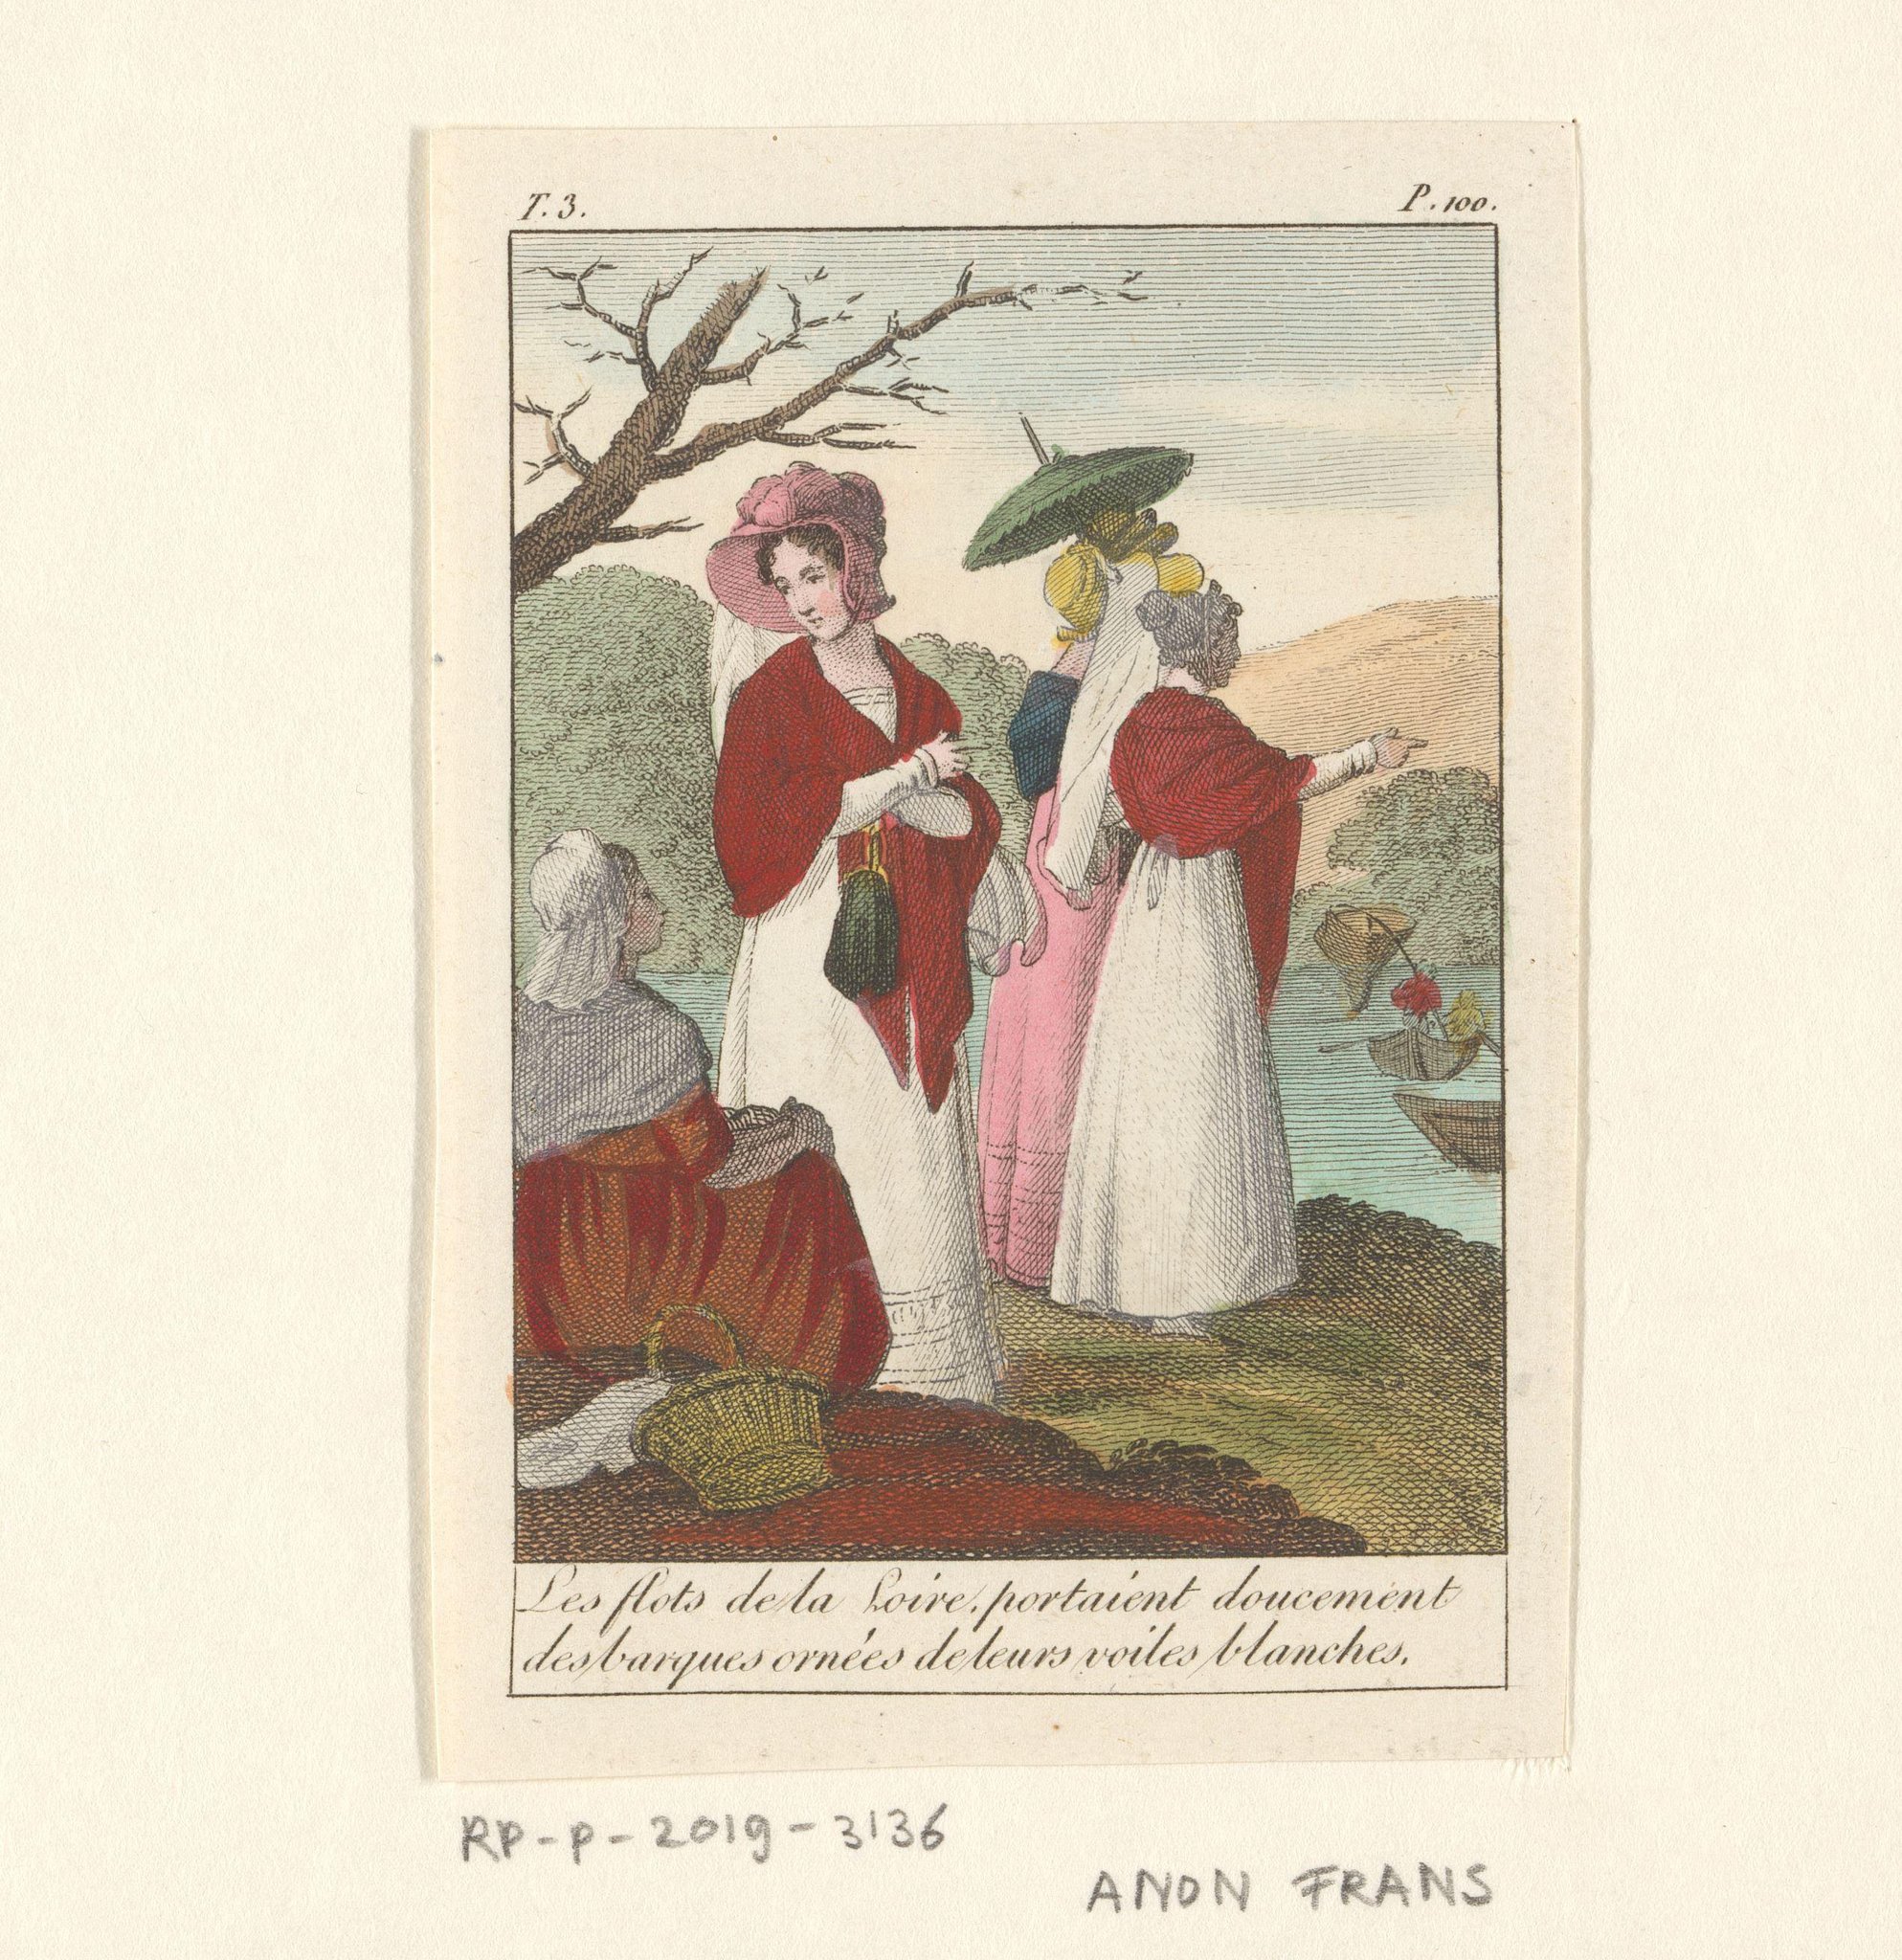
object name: print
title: Vier vrouwen aan de waterkant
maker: Anonymous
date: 1800-1899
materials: paper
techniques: etching, hand coloring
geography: france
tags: river, parasol, sunshade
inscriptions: collector's mark: Lugt 2228, caption: ‘Les flots de la Loire portaient doucement/ des barques ornées de leurs voiles blanches.’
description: Prent uit deel drie van een onbekend boek, op p. 100.